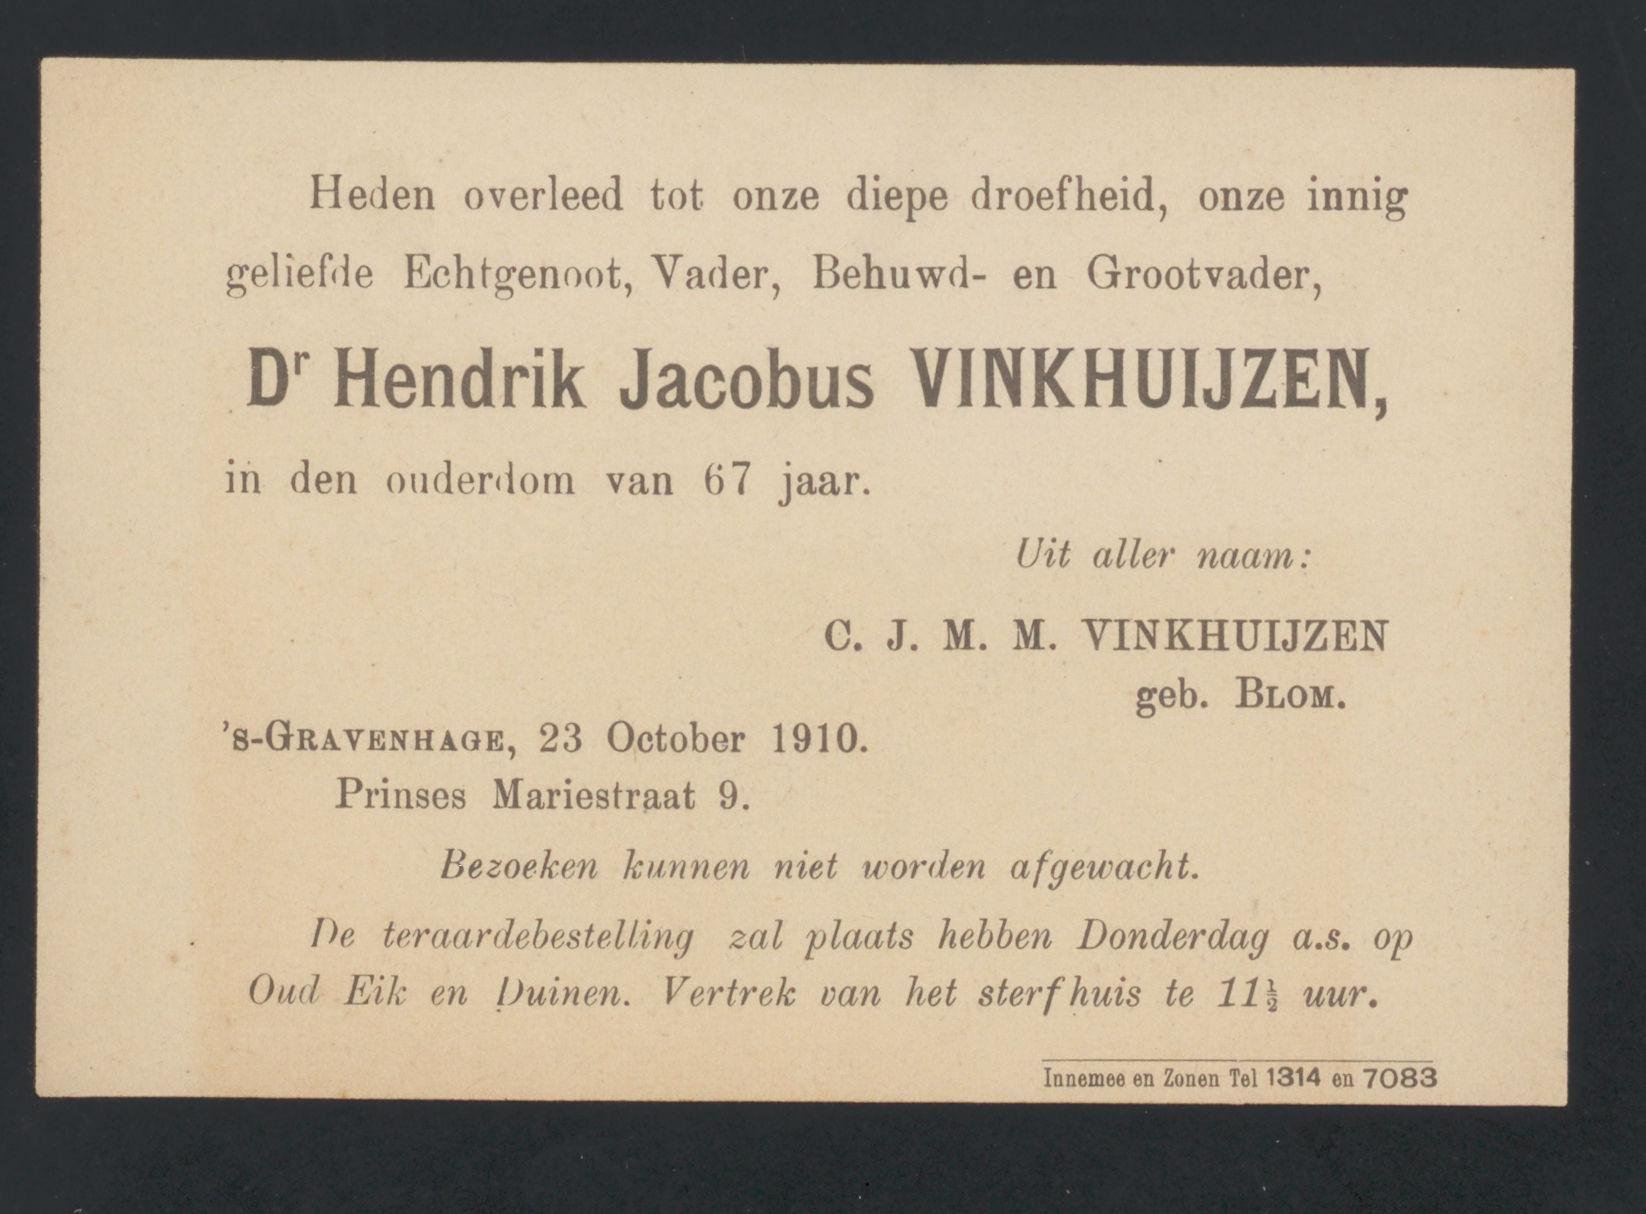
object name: overlijdensbericht, overlijdensadvertentie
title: Overlijdensbericht uit archief Philip Zilcken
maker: Anonymous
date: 1910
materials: paper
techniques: printing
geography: the hague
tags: the hague, painter, draughtsman, philip zilcken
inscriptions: collector's mark: ‘RPK’